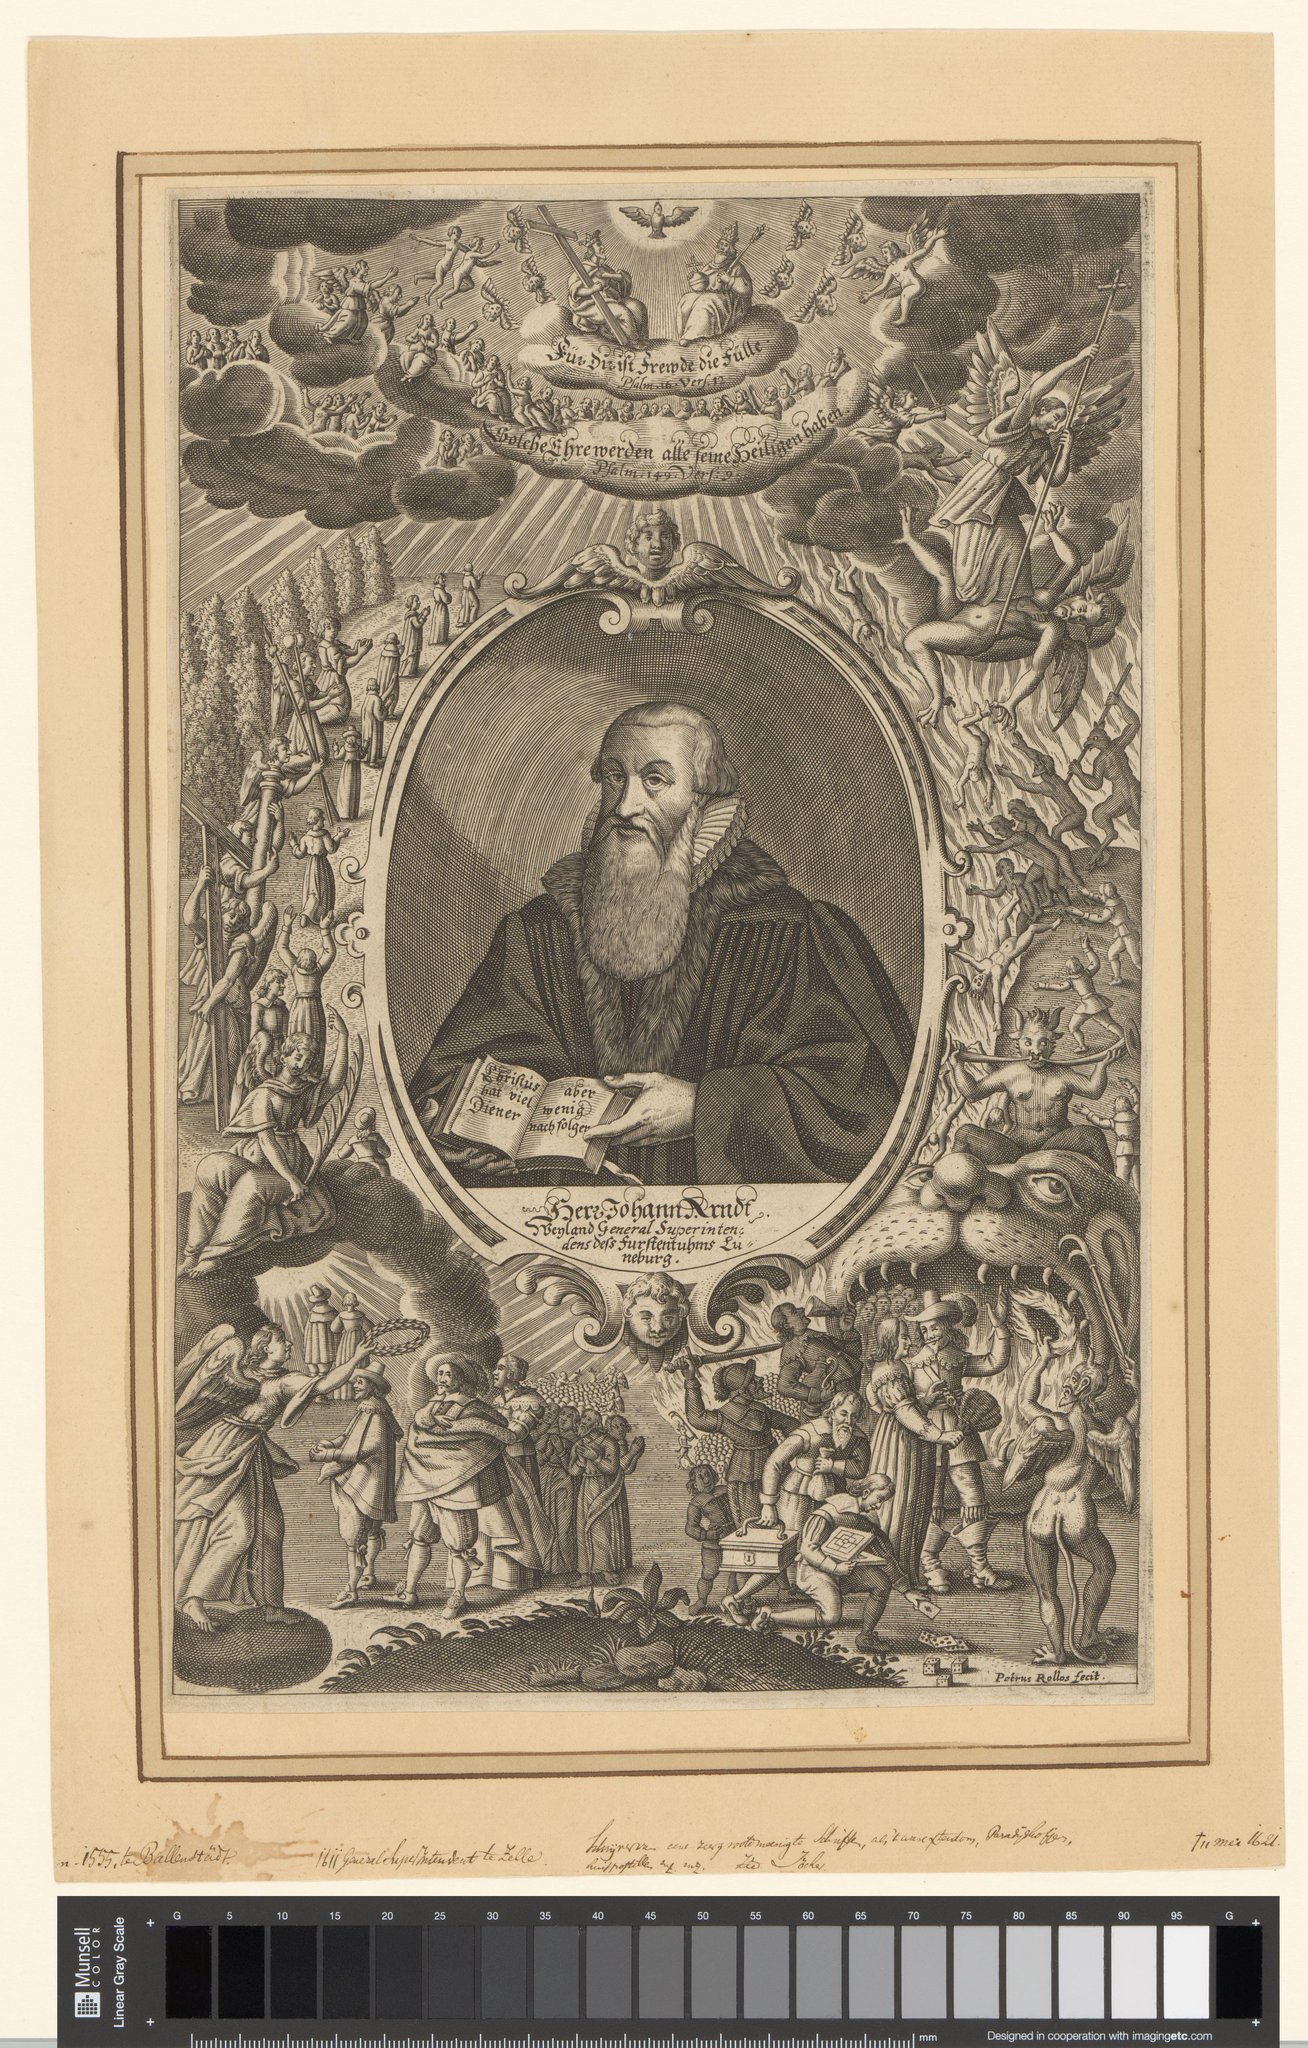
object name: print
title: Portret van Johann Arndt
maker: peter rollos (i)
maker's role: print maker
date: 1638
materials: paper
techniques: engraving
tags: theologian, last judgement, historical persons, book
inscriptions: collector's mark: Lugt 2228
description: Prent ook gebruikt in: Arndt, Johann. Wahres Christentum. Lüneburg: Gebrüder Stern, 1638.